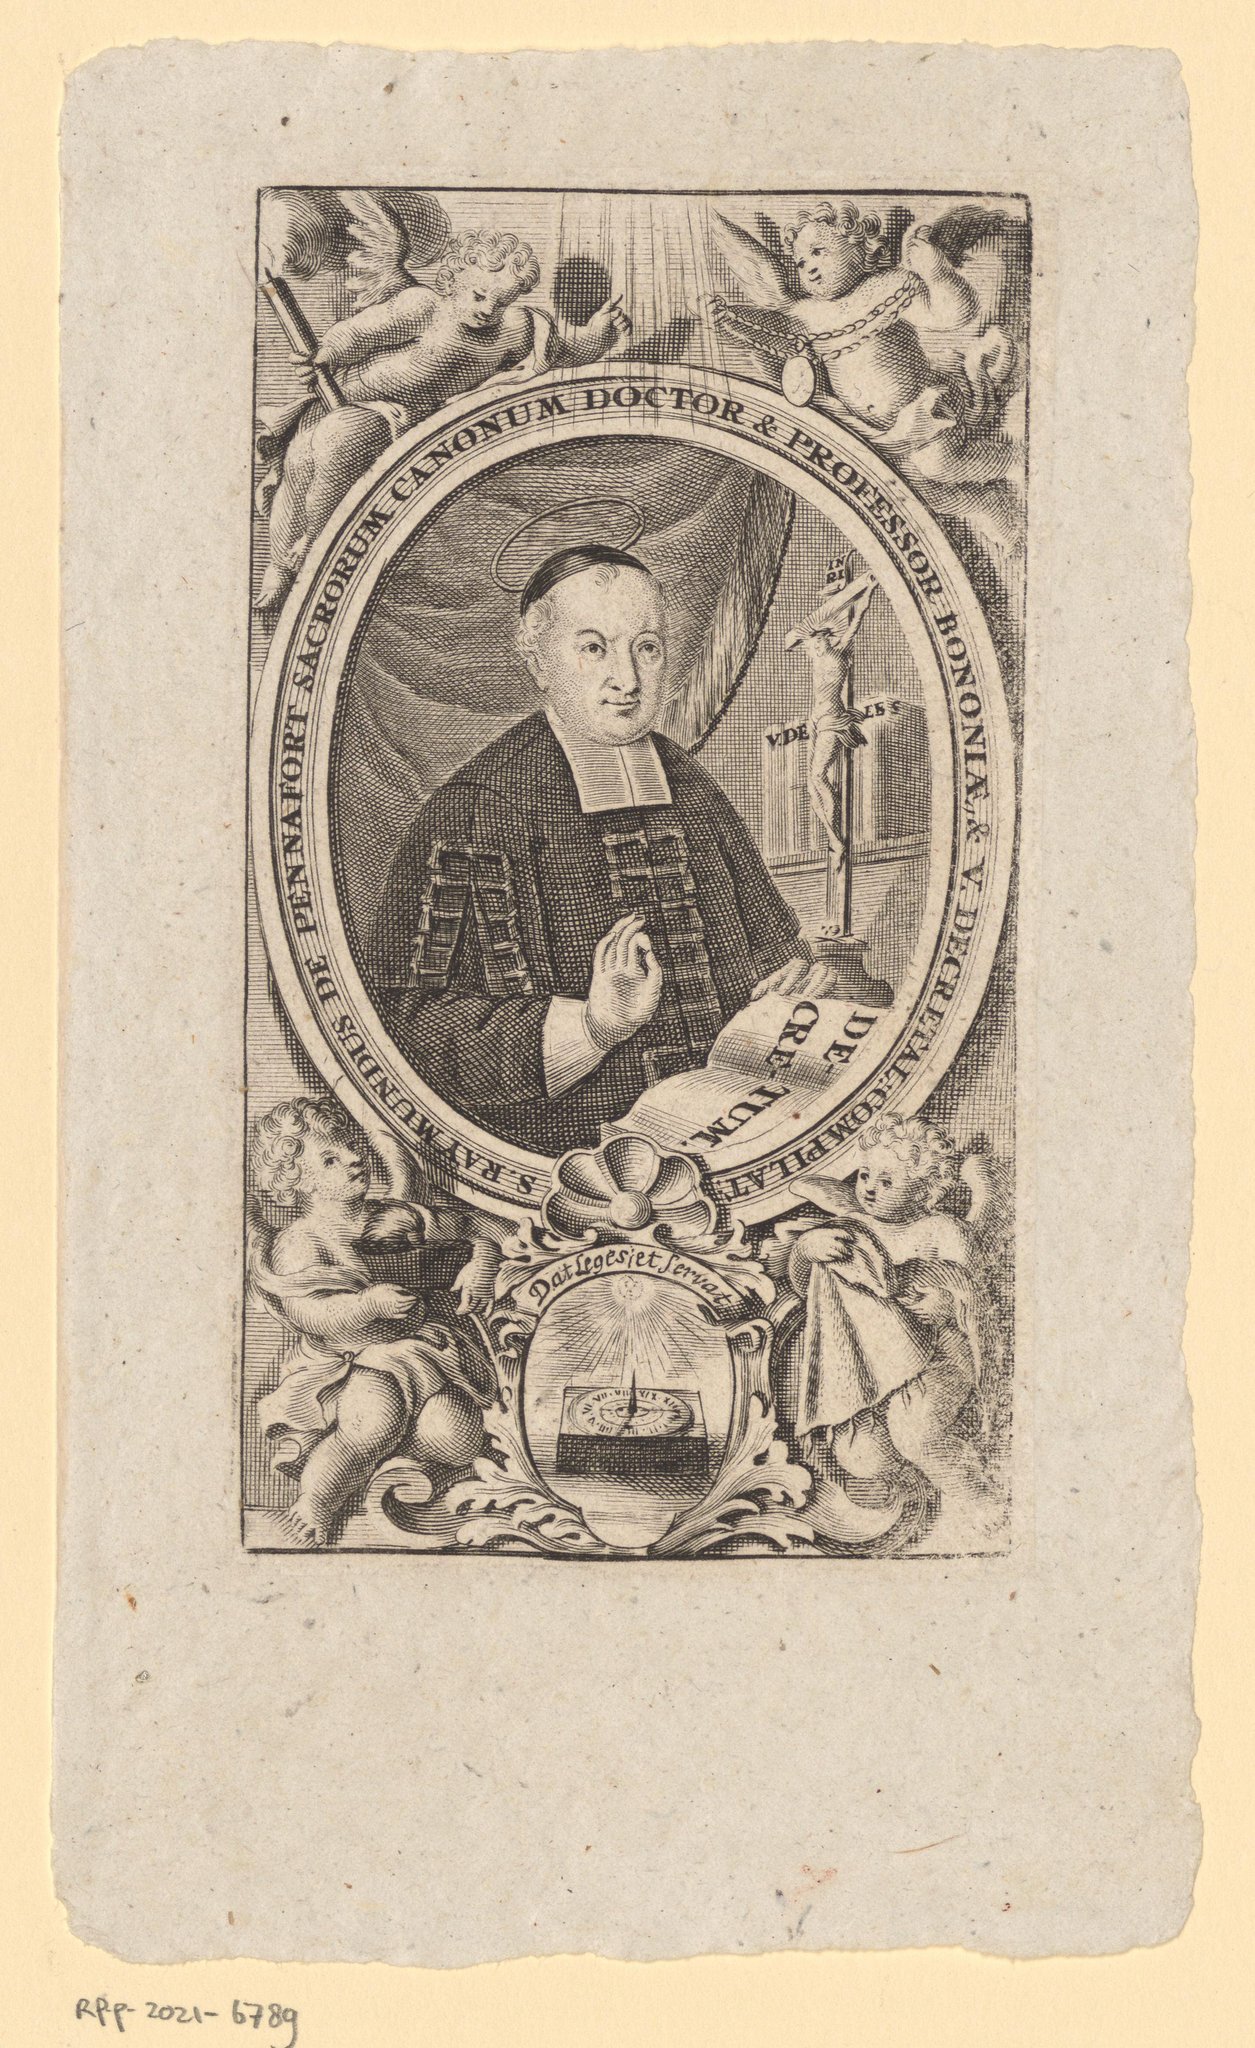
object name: print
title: Portret van Raymundus van Peñafort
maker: Anonymous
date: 1600-1699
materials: paper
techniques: engraving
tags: altarcross, crucifix, historical persons, sundial